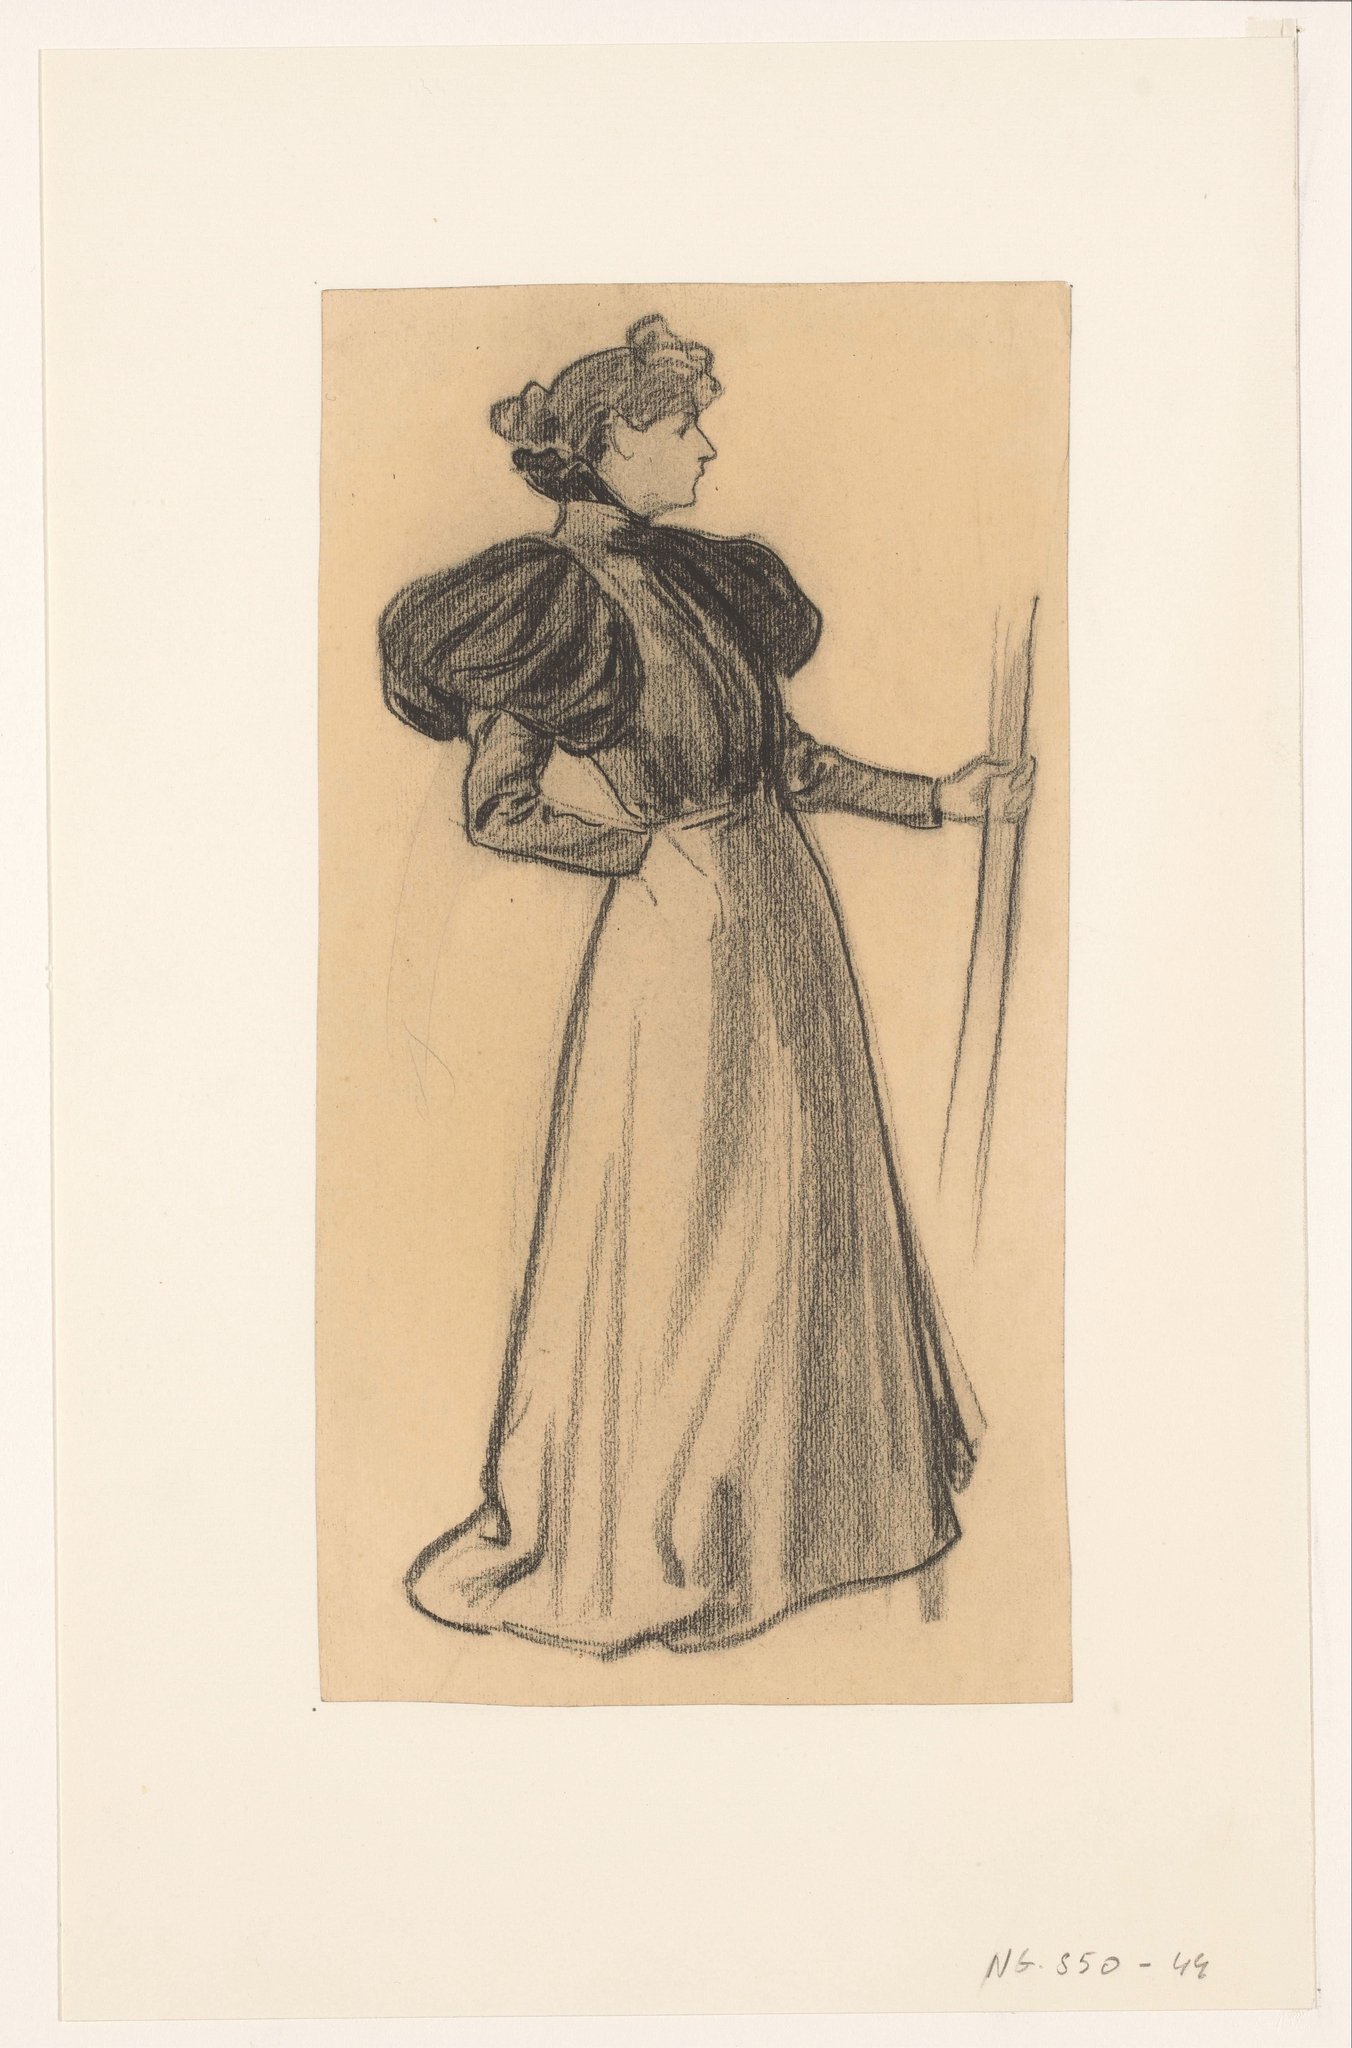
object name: drawing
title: Staande vrouw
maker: jan de waardt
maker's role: draughtsman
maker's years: 1871-1909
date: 1881-1899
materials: chalk, paper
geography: netherlands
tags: standing figure - aa - female human figure, netherlands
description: Studie van een staande jonge vrouw, naar rechts, ten voeten uit, in een lange japon. De rechterhand op de rechterheup, in de linkerhand een stok.